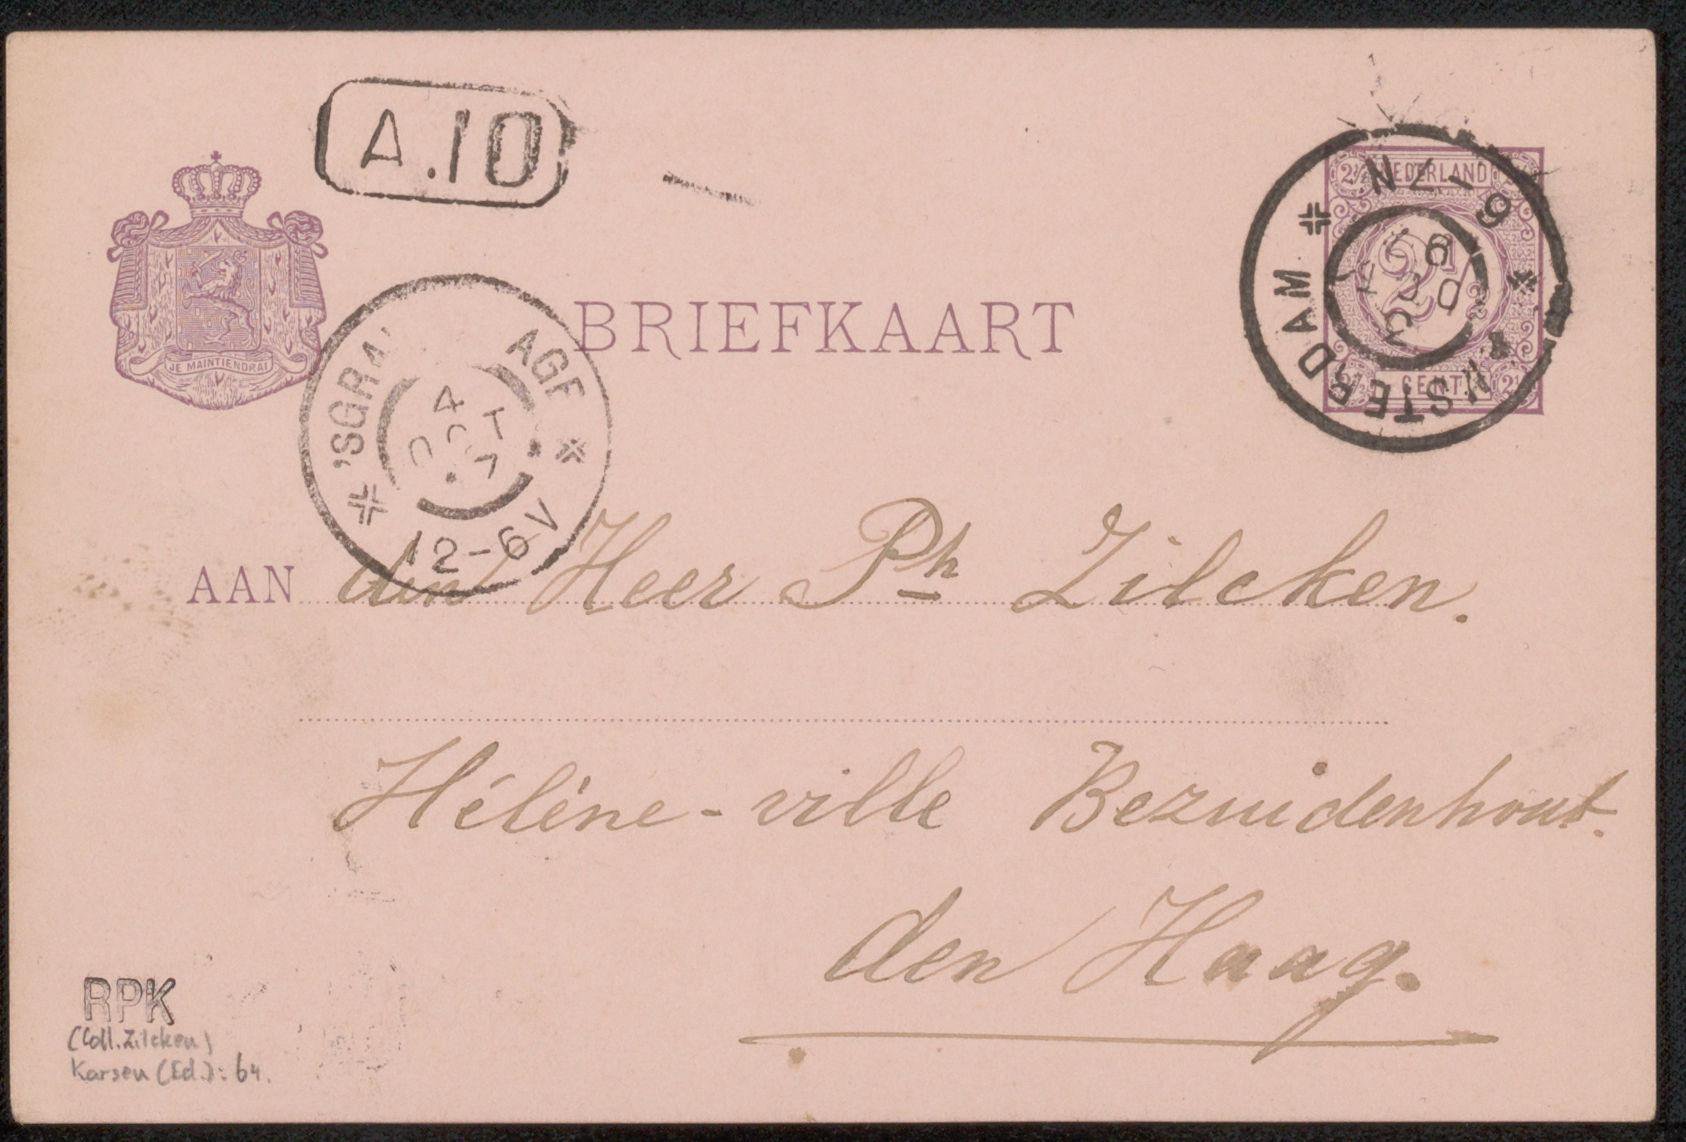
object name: postcard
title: Briefkaart aan Philip Zilcken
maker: eduard karsen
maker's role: draughtsman, painter, print maker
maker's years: 1860-1941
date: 1897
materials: cardboard, ink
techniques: pen, writing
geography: amsterdam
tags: the hague, philip zilcken, the graphic arts, money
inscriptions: collector's mark: ‘RPK’